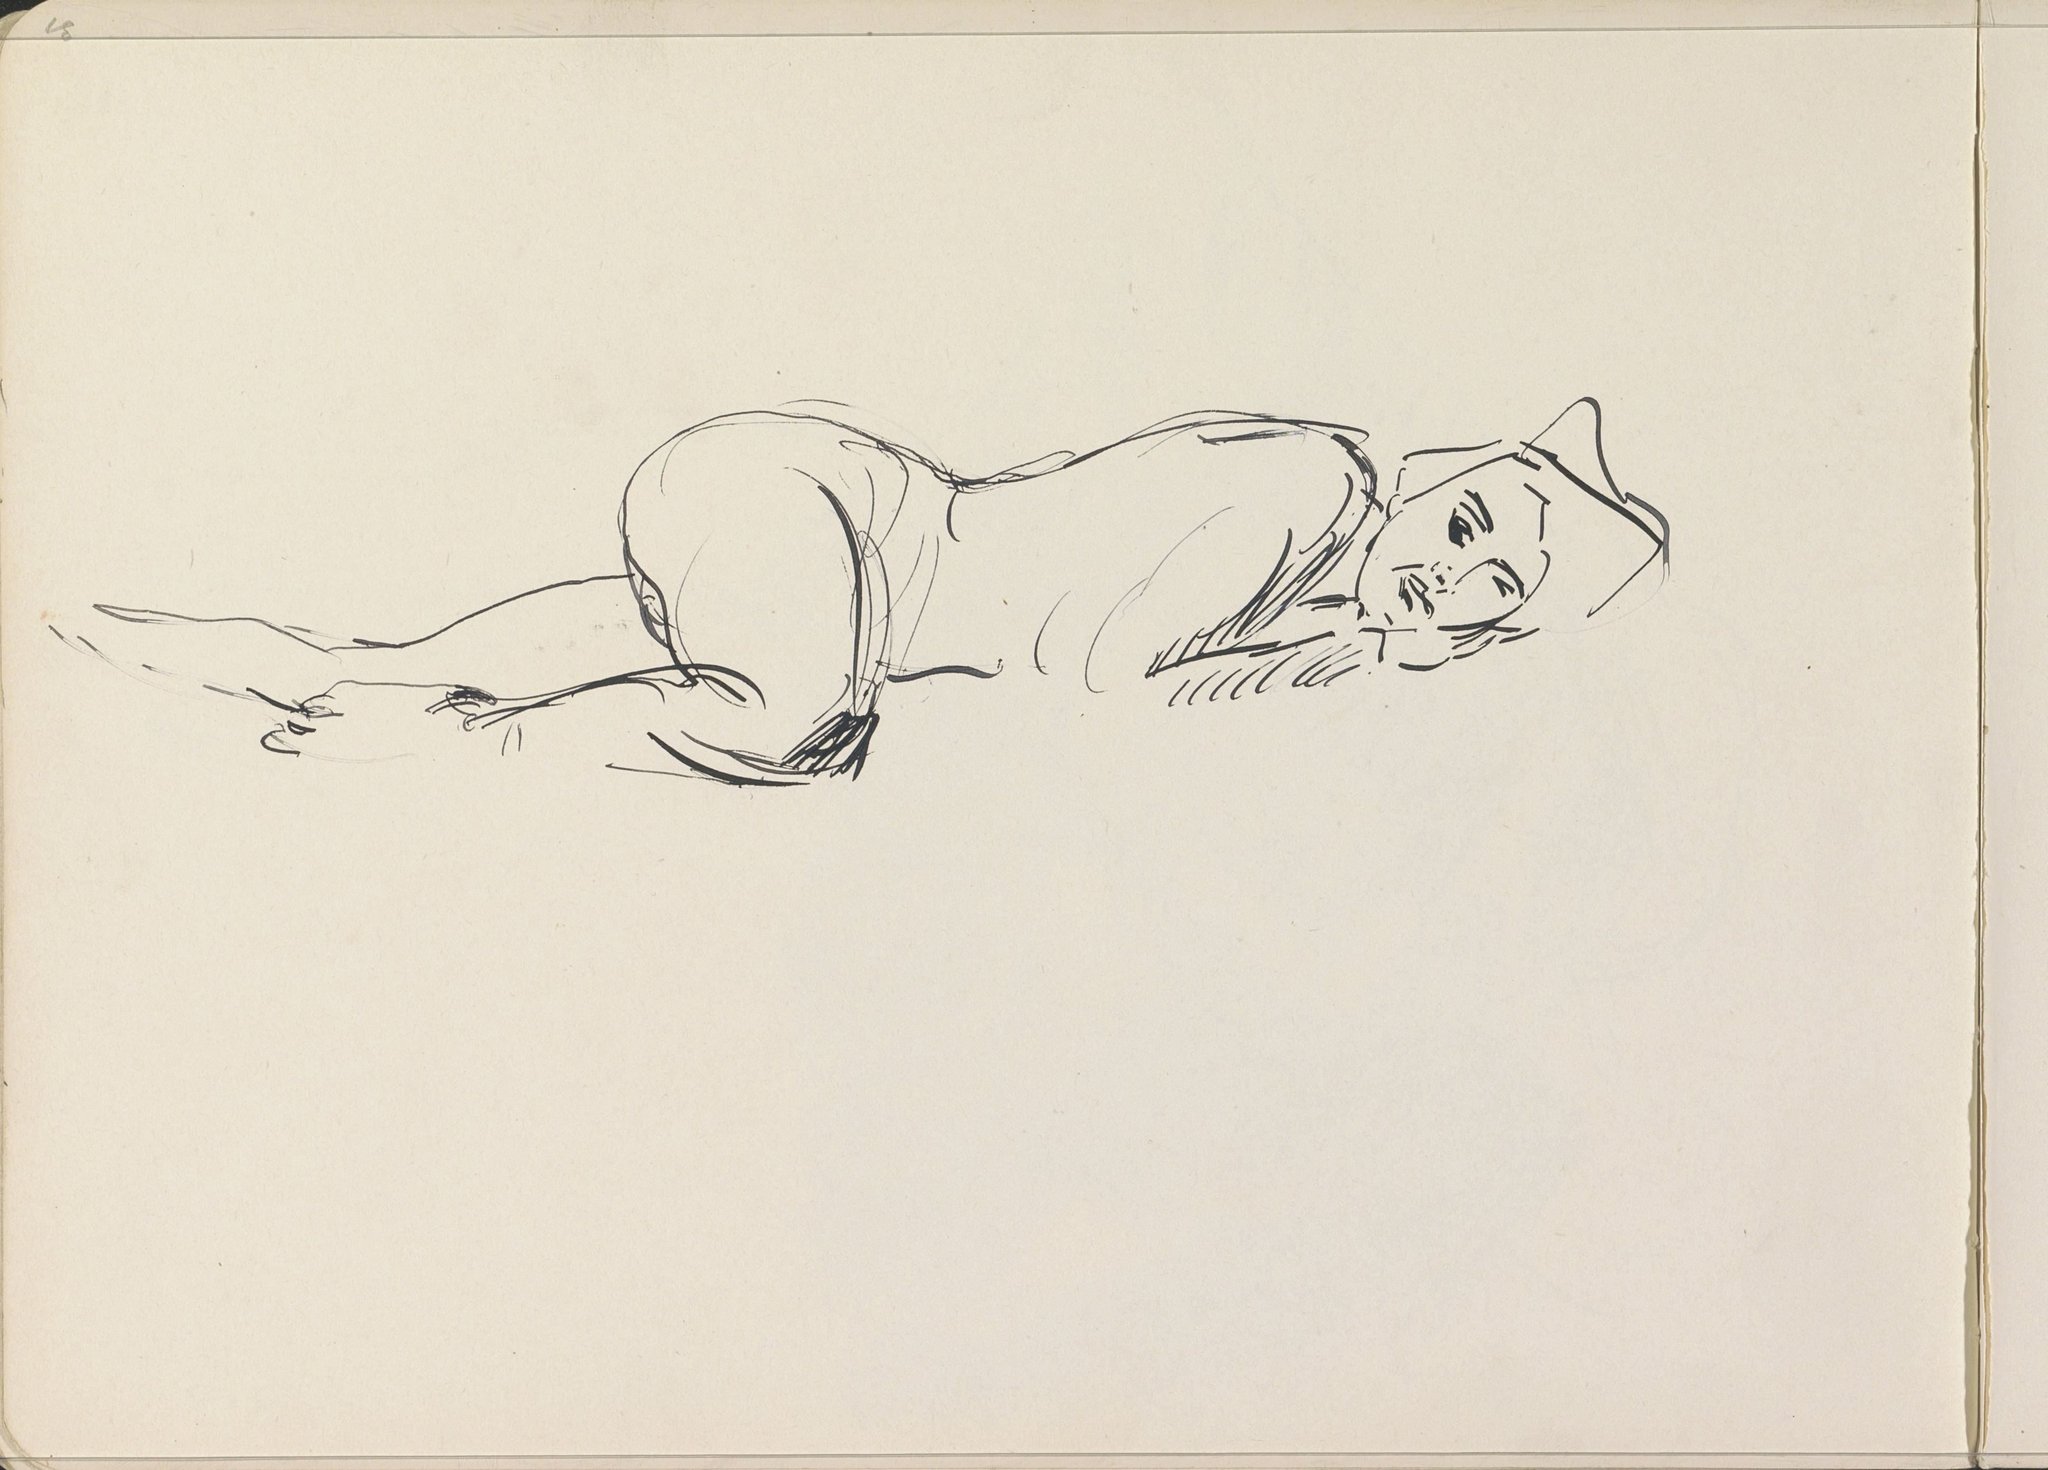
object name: sketchbook leaf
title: Reclining Female Nude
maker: isaac israels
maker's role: draughtsman, painter, print maker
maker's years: 1865-1934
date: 1875-1934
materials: ink, paper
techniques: pen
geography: the hague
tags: lying figure - aa - female human figure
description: Ze ligt op haar buik met een opgetrokken been. Haar handen liggen onder haar hoofd. Blad 16 verso uit schetsboek II met 23 bladen.